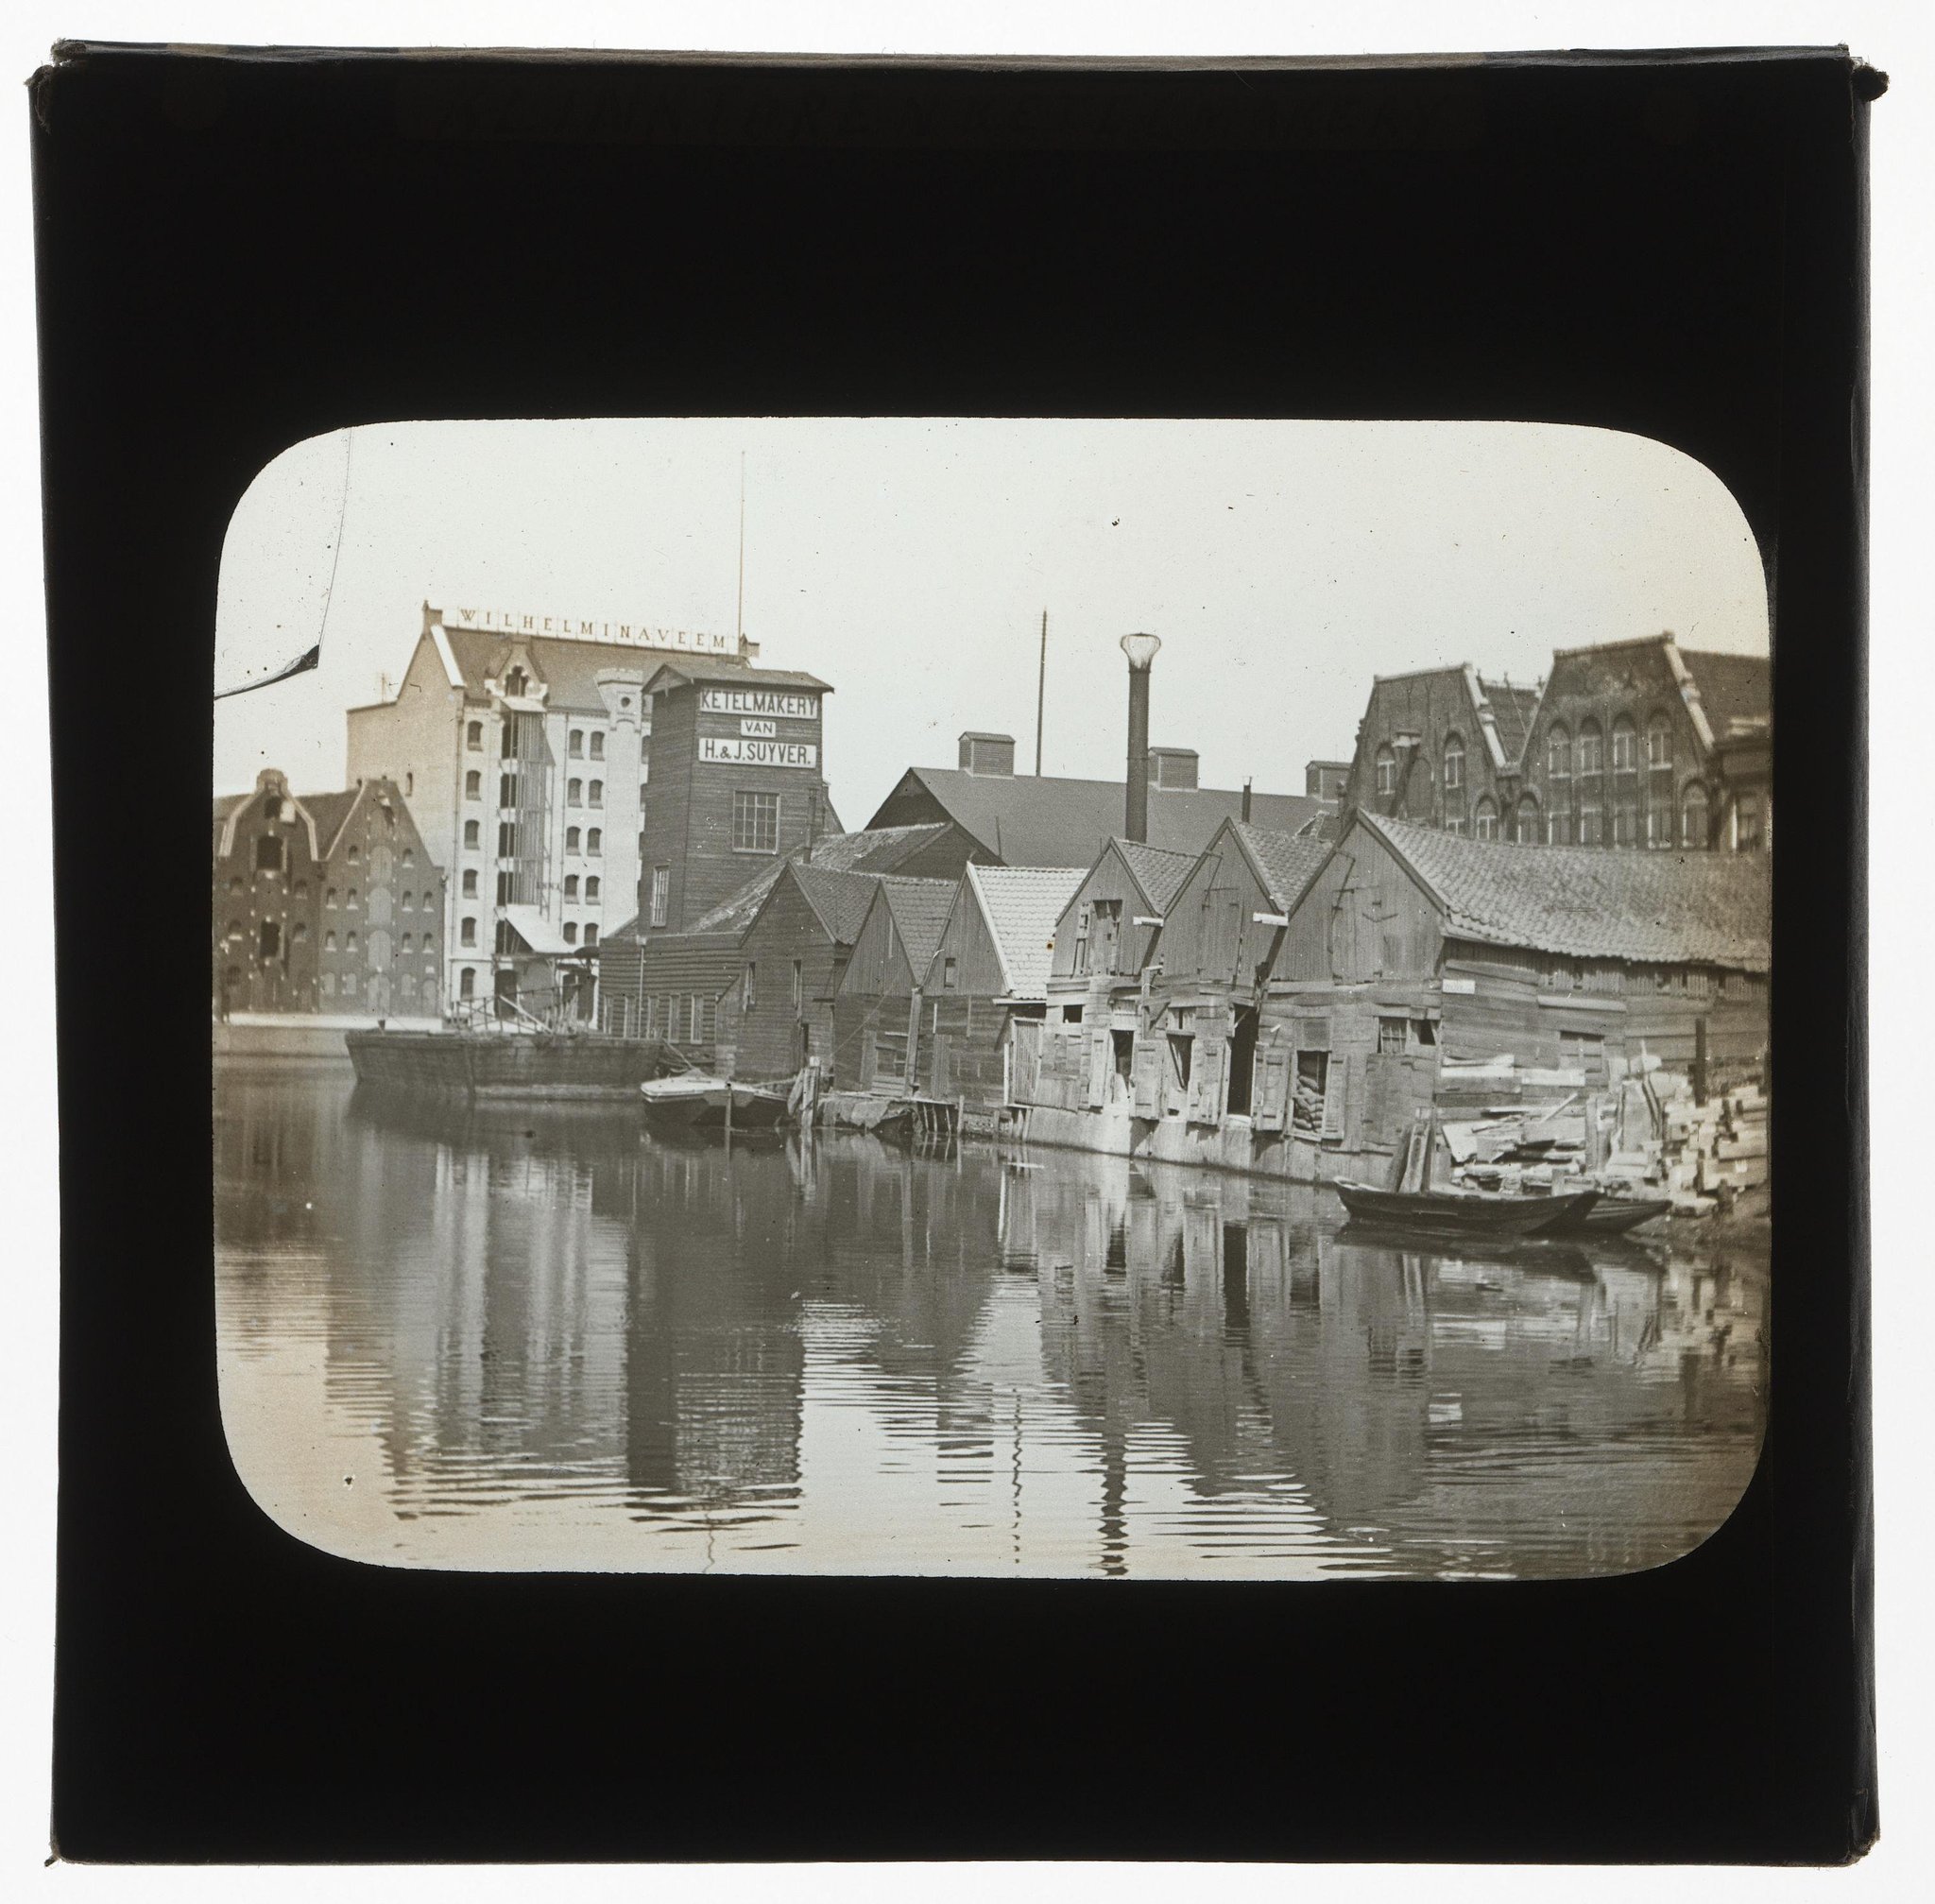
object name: lantern slide photographic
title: Gezicht op ketelmakerij H. & J. Suyver in de Wilhelminahaven, mogelijk Dordrecht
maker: machiel gerrit george suyver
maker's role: fotograaf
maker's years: 1872-1933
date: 1900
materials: glass, paper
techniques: gelatin silver transparency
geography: amsterdam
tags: harbour, heavy industry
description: Klinktoren van ketelmakerij H. & J. Suyver, hoek Bickersgracht en Realengracht, Amsterdam. Op de achtergrond het pand van het Wilhelminaveem.